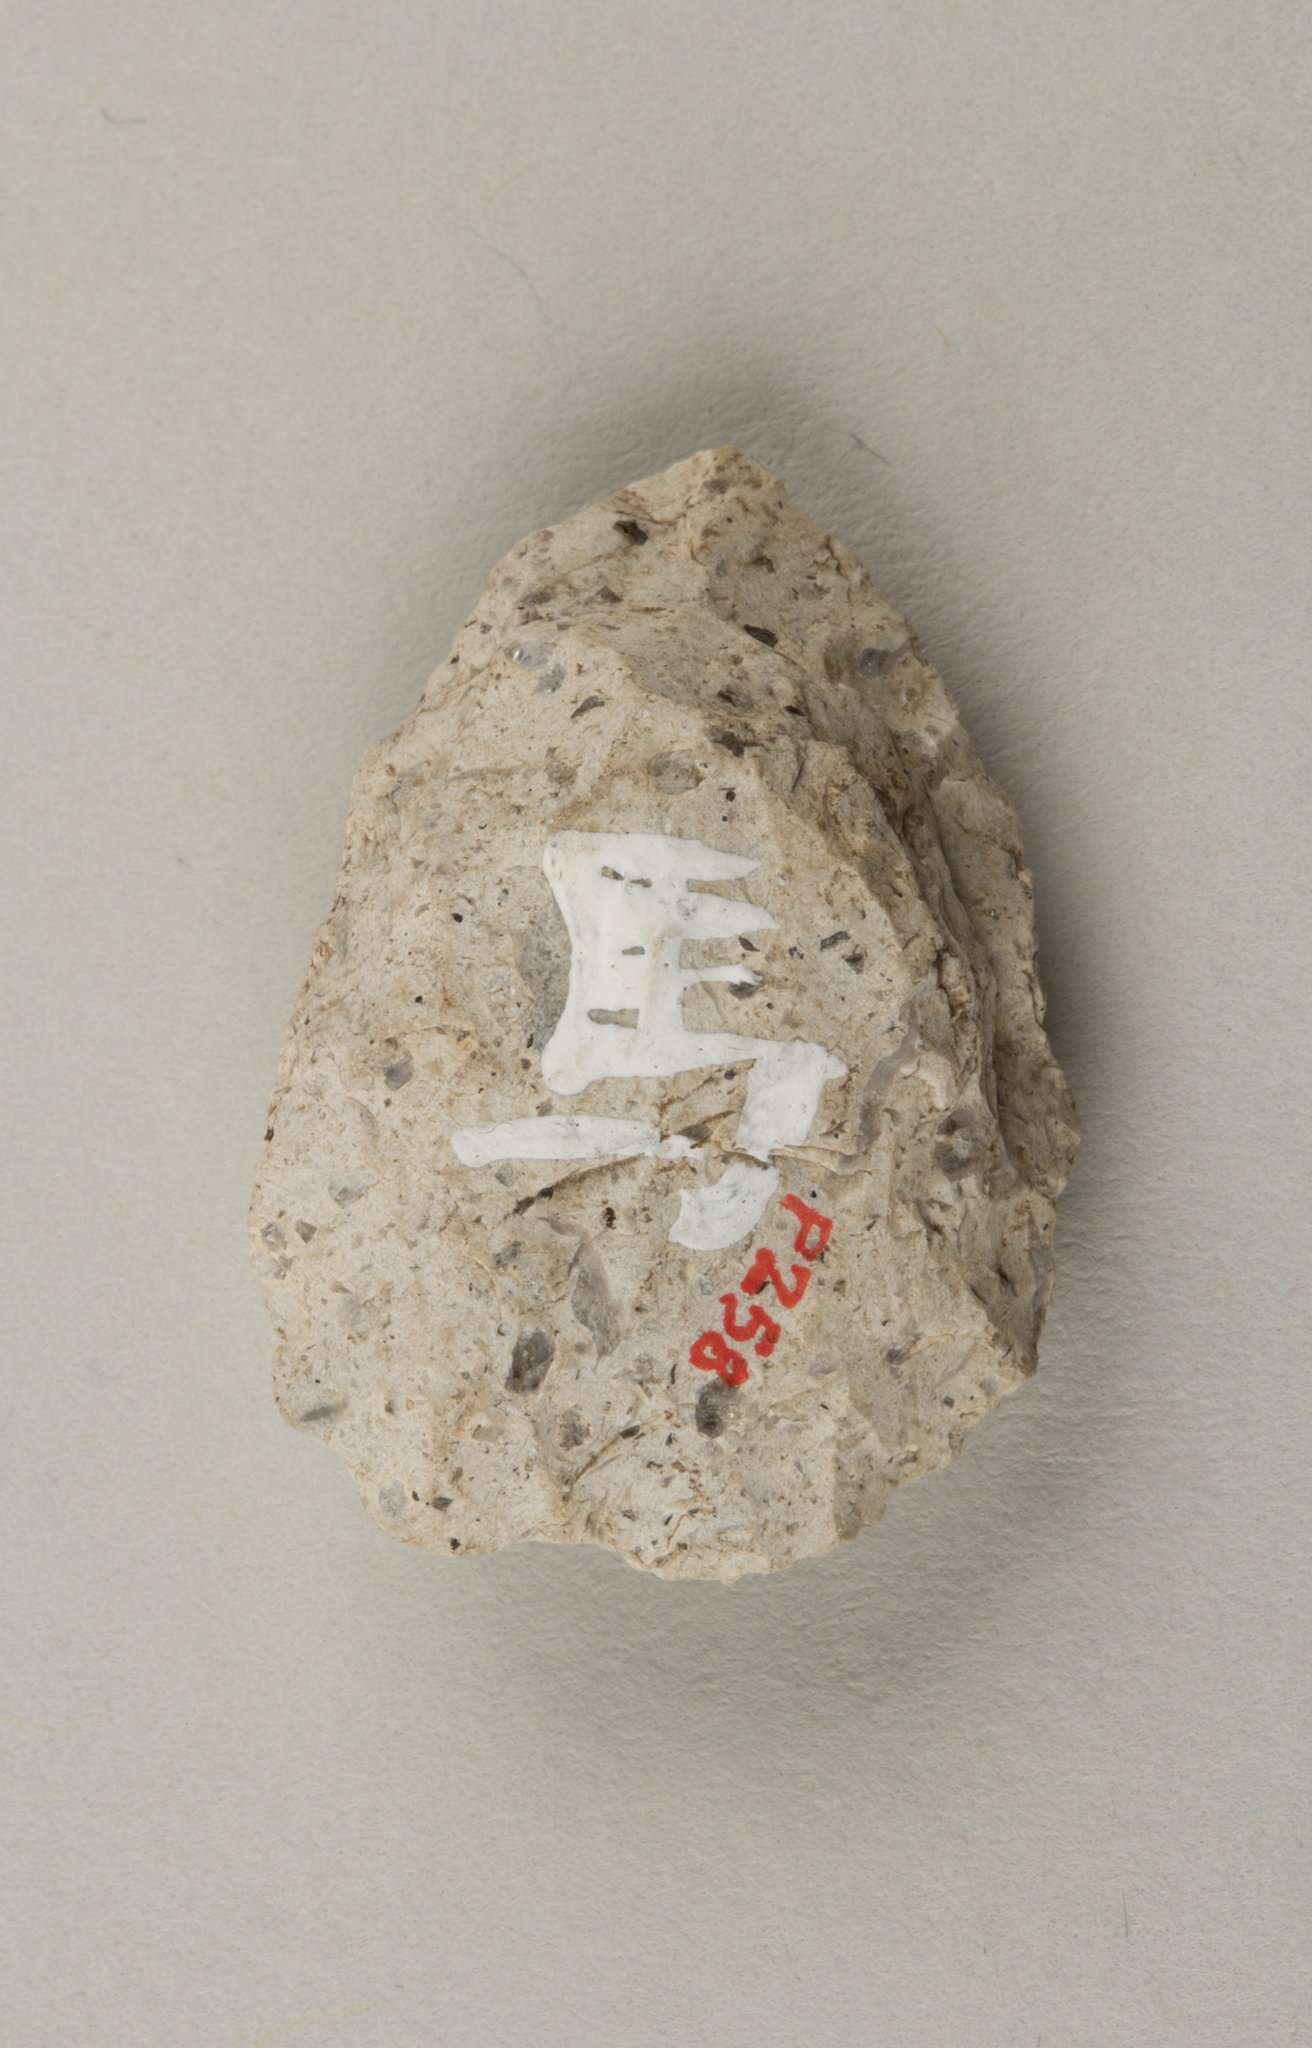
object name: arrowhead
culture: japanese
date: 1500-1000 BCE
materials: stone